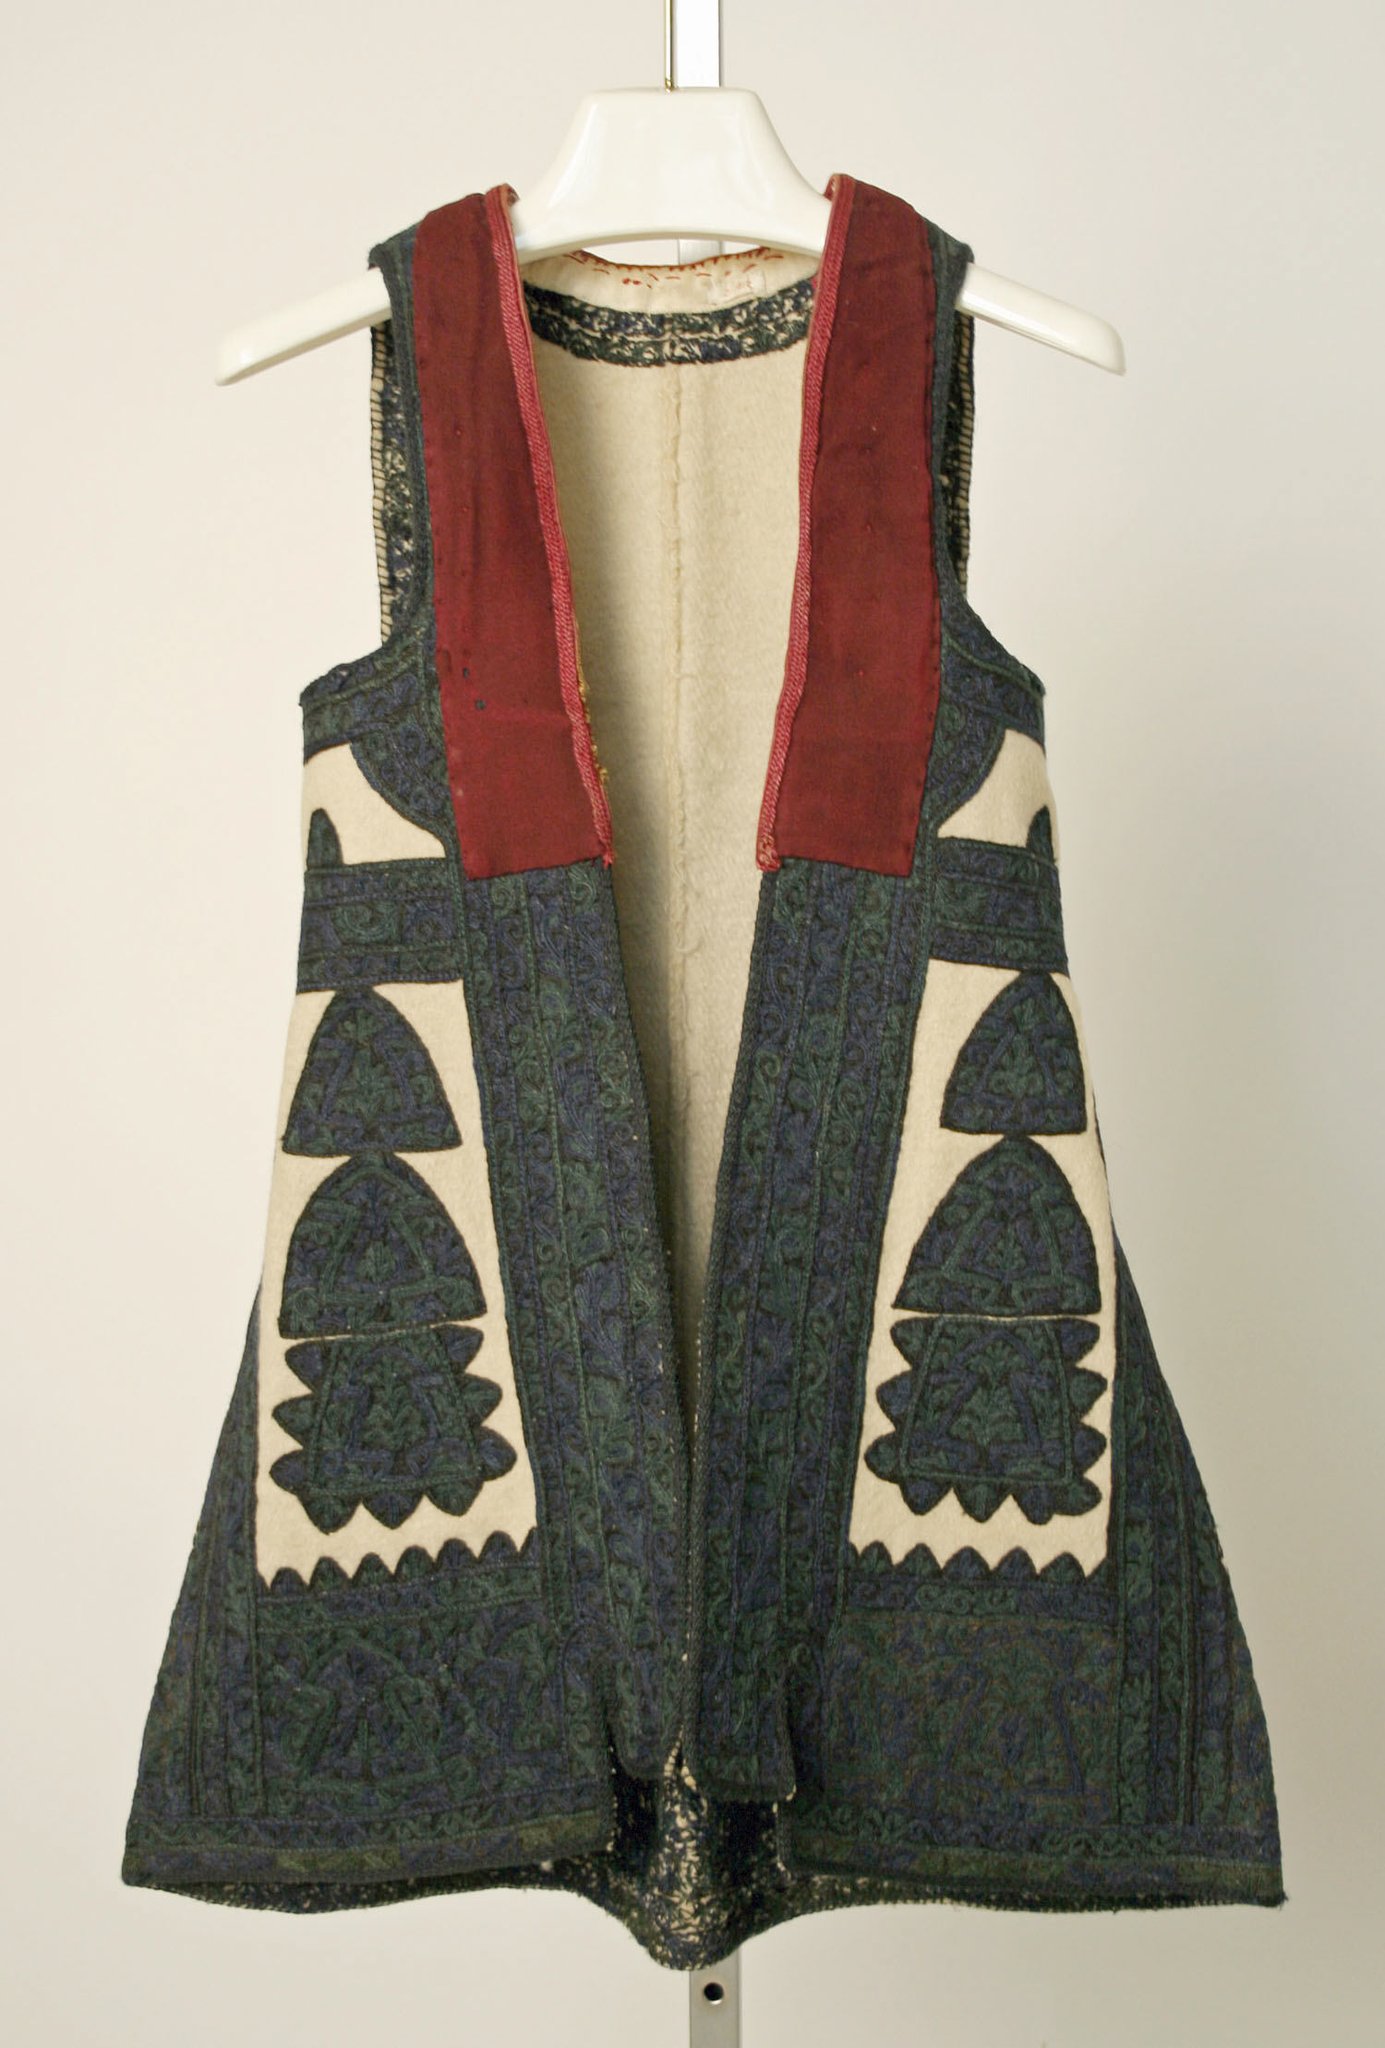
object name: jacket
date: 1801-1900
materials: silk, wool